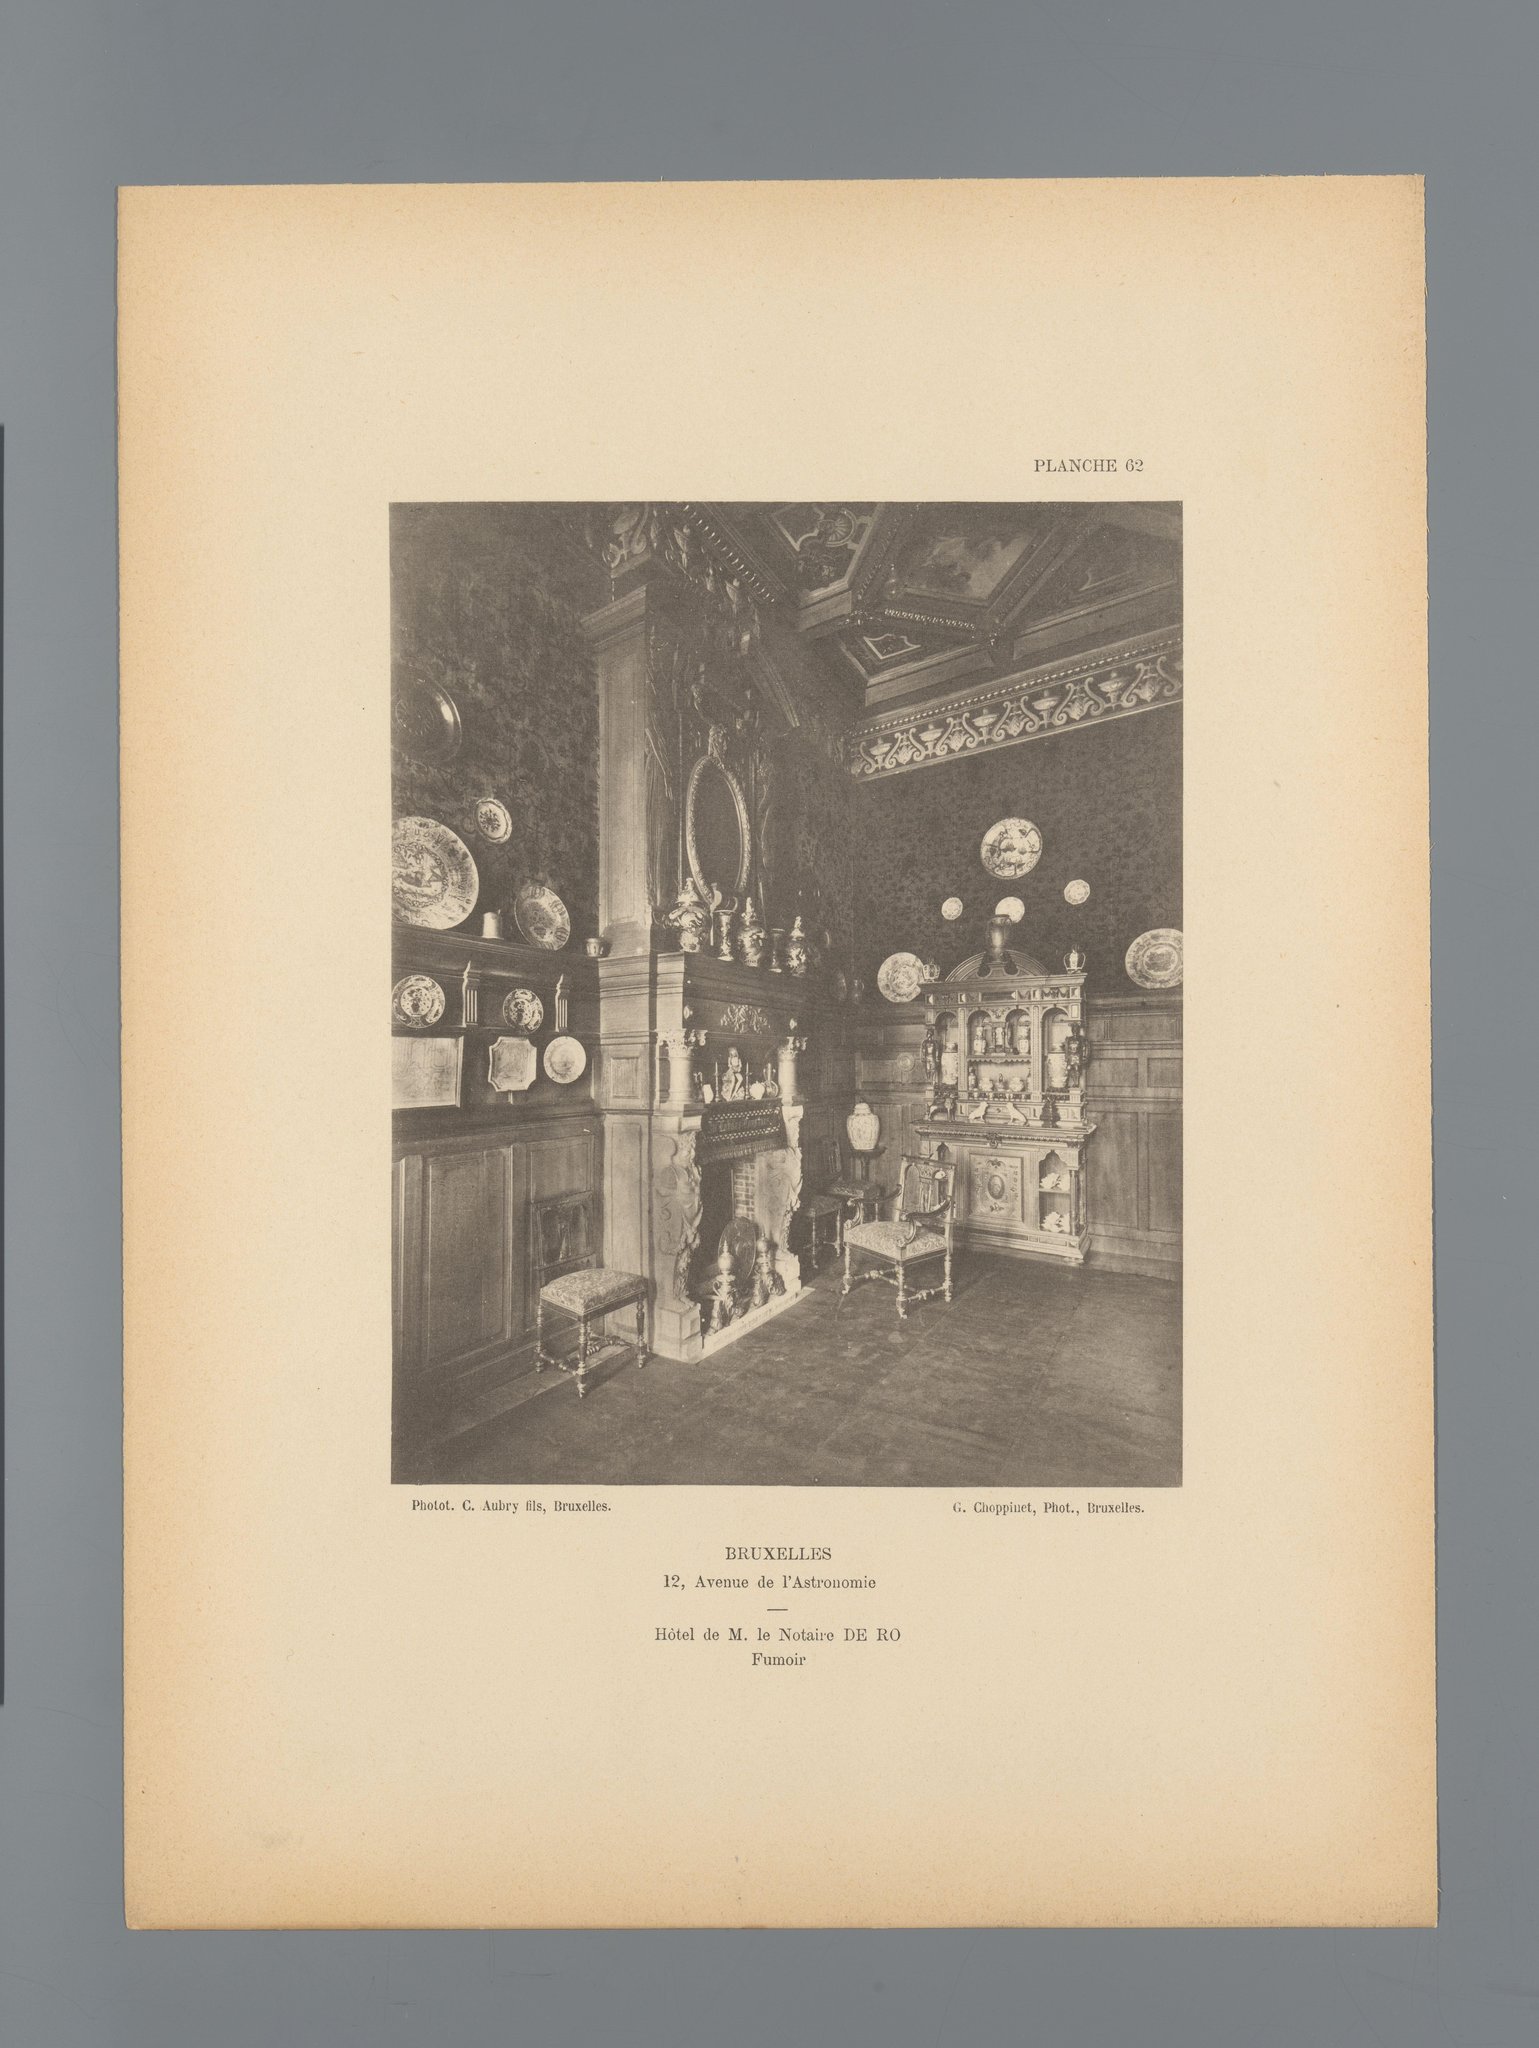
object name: photomechanical print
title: Gezicht op een rookruimte in het hotel van De Ro in Brussel, België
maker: gustave choppinet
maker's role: fotograaf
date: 1893-1898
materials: paper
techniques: photograph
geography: brussels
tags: interior of the house, hotel, hostelry, inn, brussels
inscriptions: number: ‘PLANCHE 62’, inscription: ‘12, Avenue de l'Astronomie/ Hôtel de M. le Notaire DE RO/ Fumoir’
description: Deze prent maakt deel uit van een omslag met 89 prenten en 5 tekstbladen.